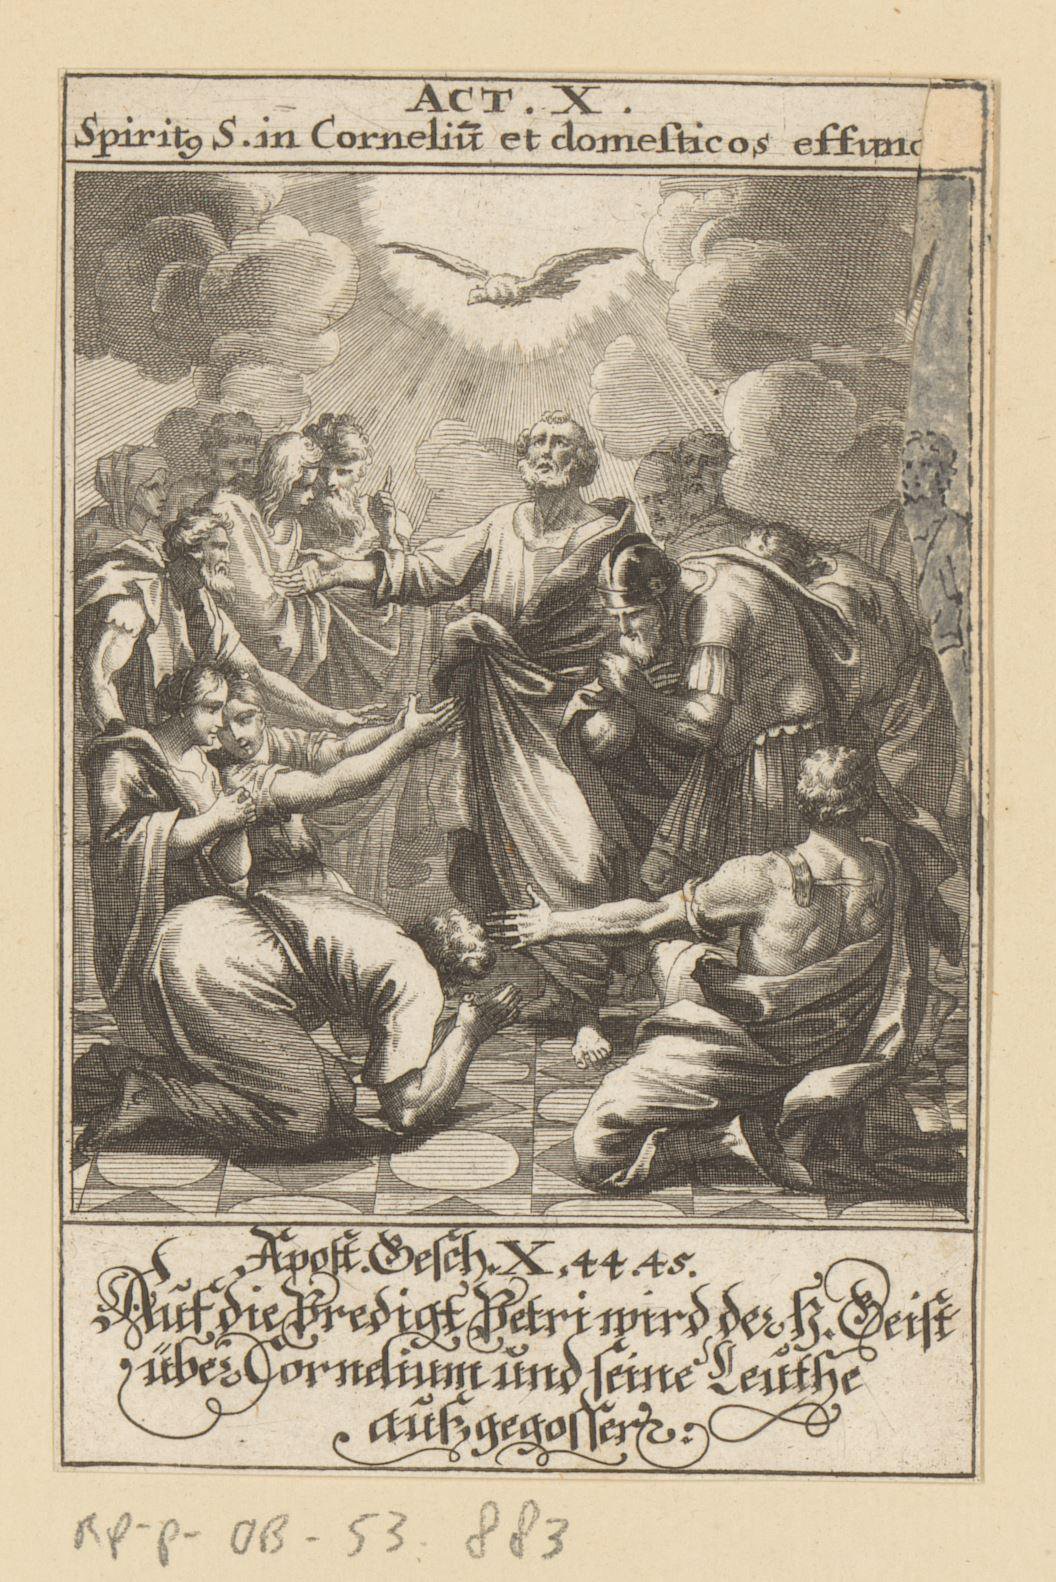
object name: print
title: Heilige Geest verschijnt aan hoofdman Cornelius en de zijnen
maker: Anonymous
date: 1697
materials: paper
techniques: etching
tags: peter in the house of cornelius: the holy ghost descends upon cornelius and his family, who are baptized by peter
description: Prent ook gebruikt in: Biblia ectypa : Bildnussen auss Heiliger Schrifft. Regensburg: Chr. Wiegel, 1697.